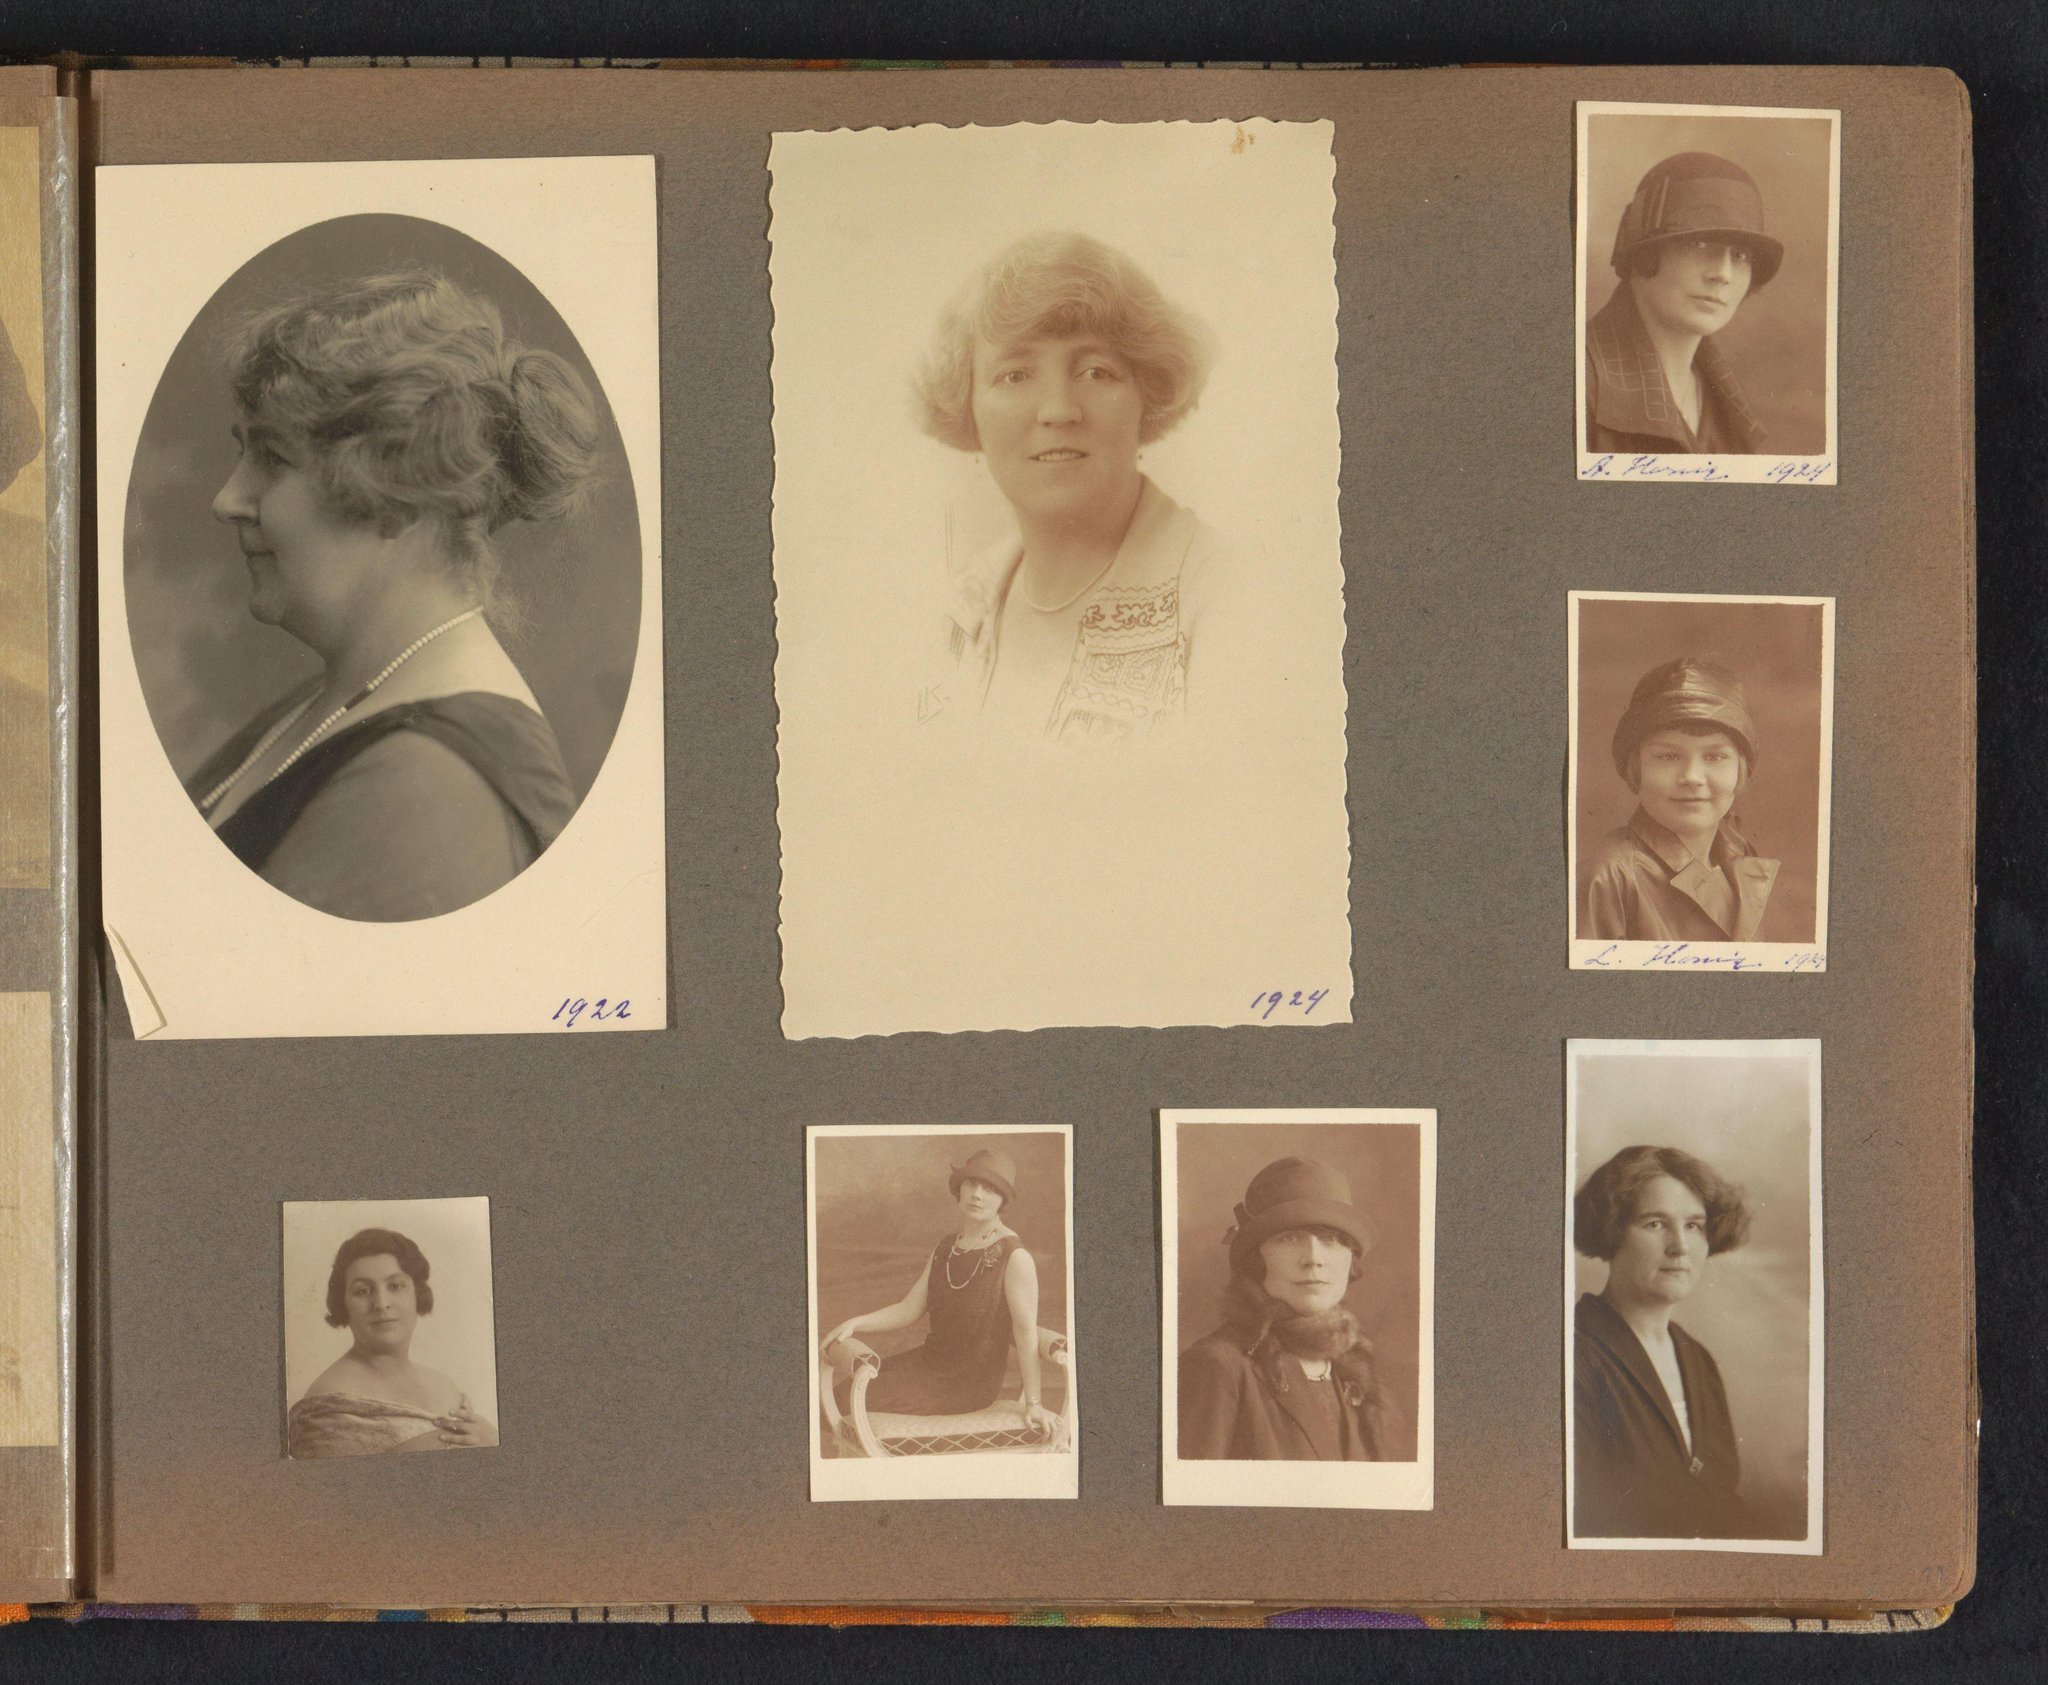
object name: photograph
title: Portretten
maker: Anonymous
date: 1922-1924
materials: cardboard, photographic support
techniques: gelatin silver print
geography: netherlands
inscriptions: signature: ‘L.K.’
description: Albumblad met portretten van jonge vrouwen. De vrouw op de foto rechtsboven is aangeduid als 'A. Honig', de vrouw daaronder als 'L. Honig'. Onderdeel van Fotoalbum van een onbekende Nederlandse familie met connecties in Suriname en Nederlands-Indië (2).